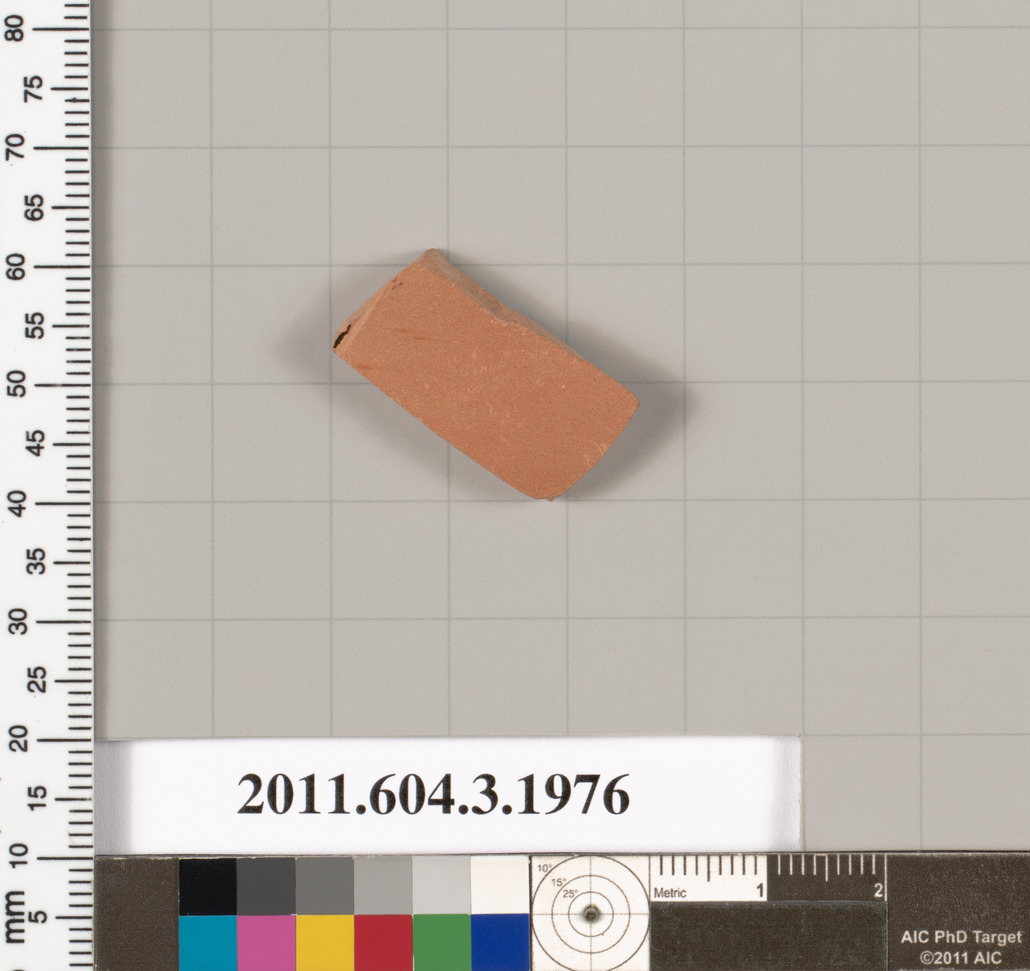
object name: kylix fragment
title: Terracotta fragment of a kylix (drinking cup)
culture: greek, attic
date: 600-501 BCE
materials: terracotta